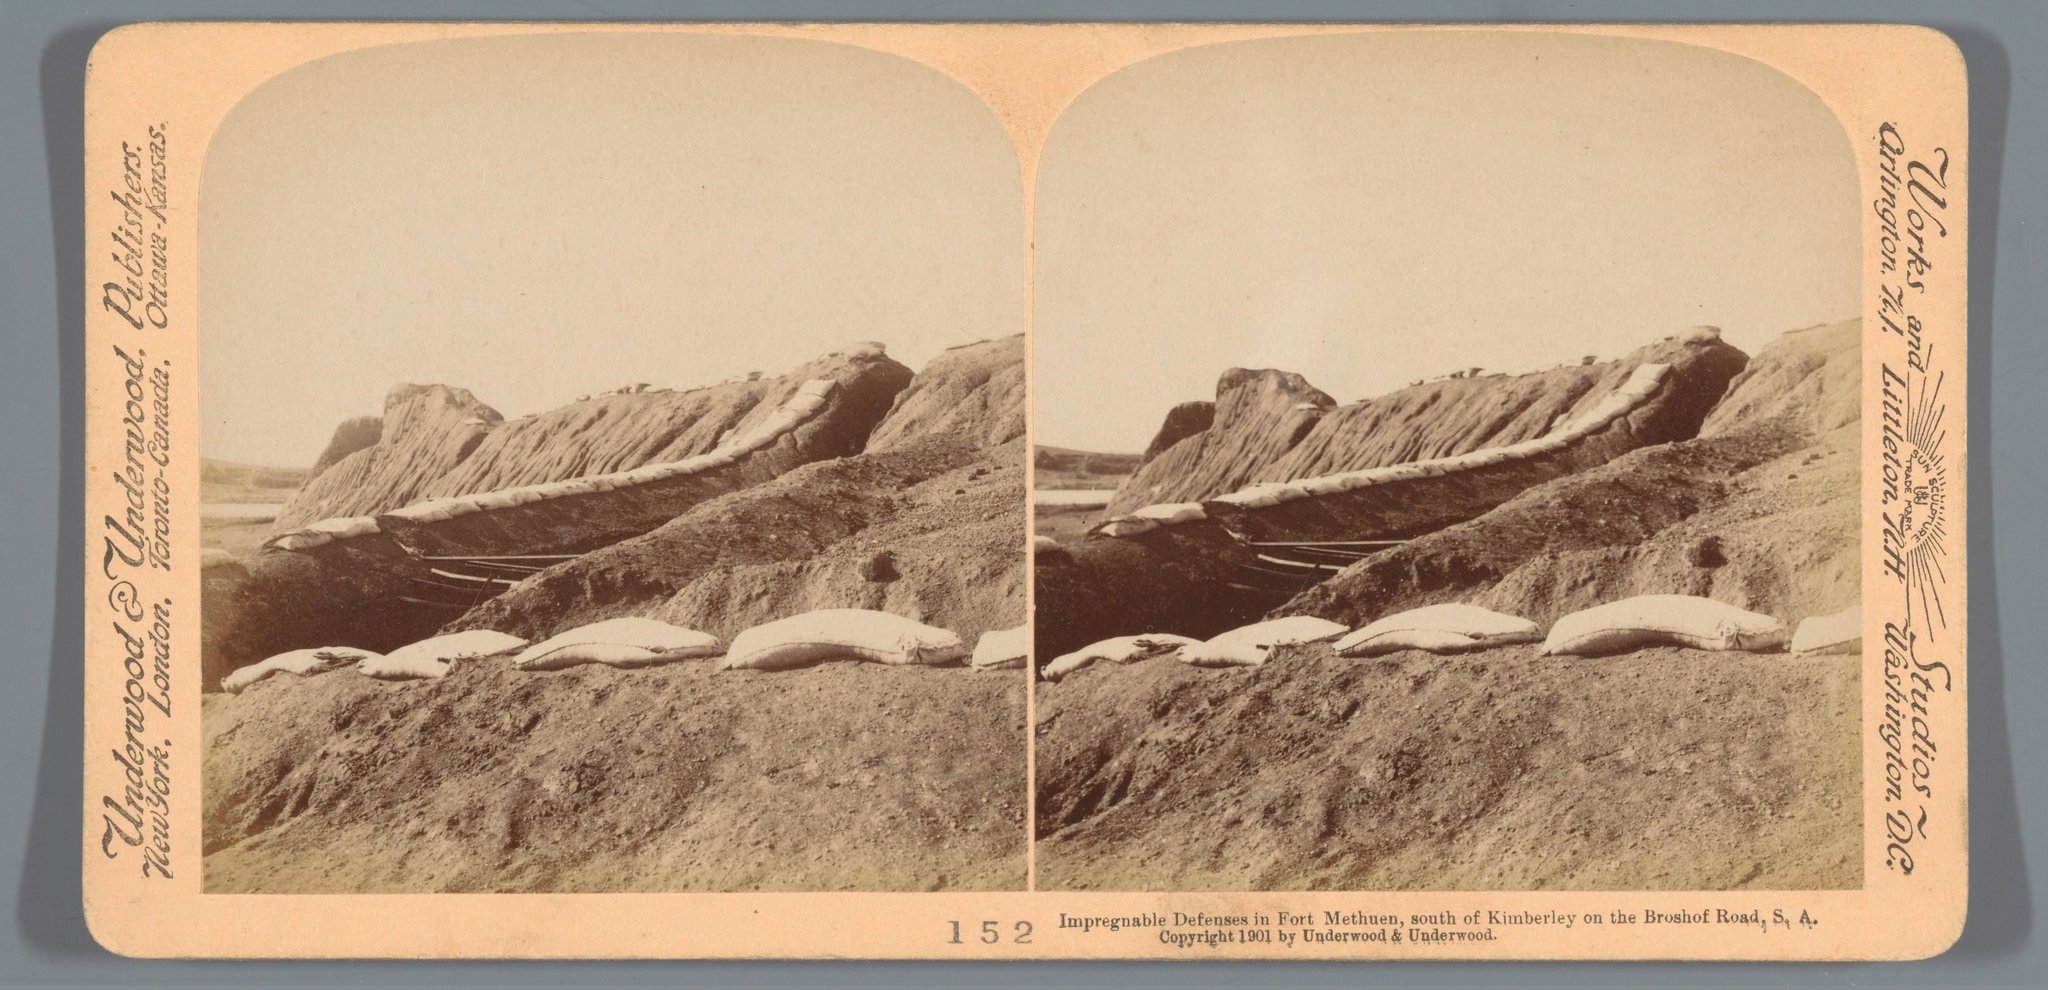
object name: stereograph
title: Impregnable Defenses in Fort Methuen, south of Kimberley on the Broshof Road, S.A.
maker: Anonymous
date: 1901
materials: cardboard, paper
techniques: albumen print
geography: kimberley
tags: defensive measures (military)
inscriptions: number: ‘152’, inscription: ‘Works and Studios ~/ Arlington, N.J. Littleton, N.H. Washington, D.C.’, inscription, copyright notice: ‘Copyright 1901 by Underwood & Underwood.’